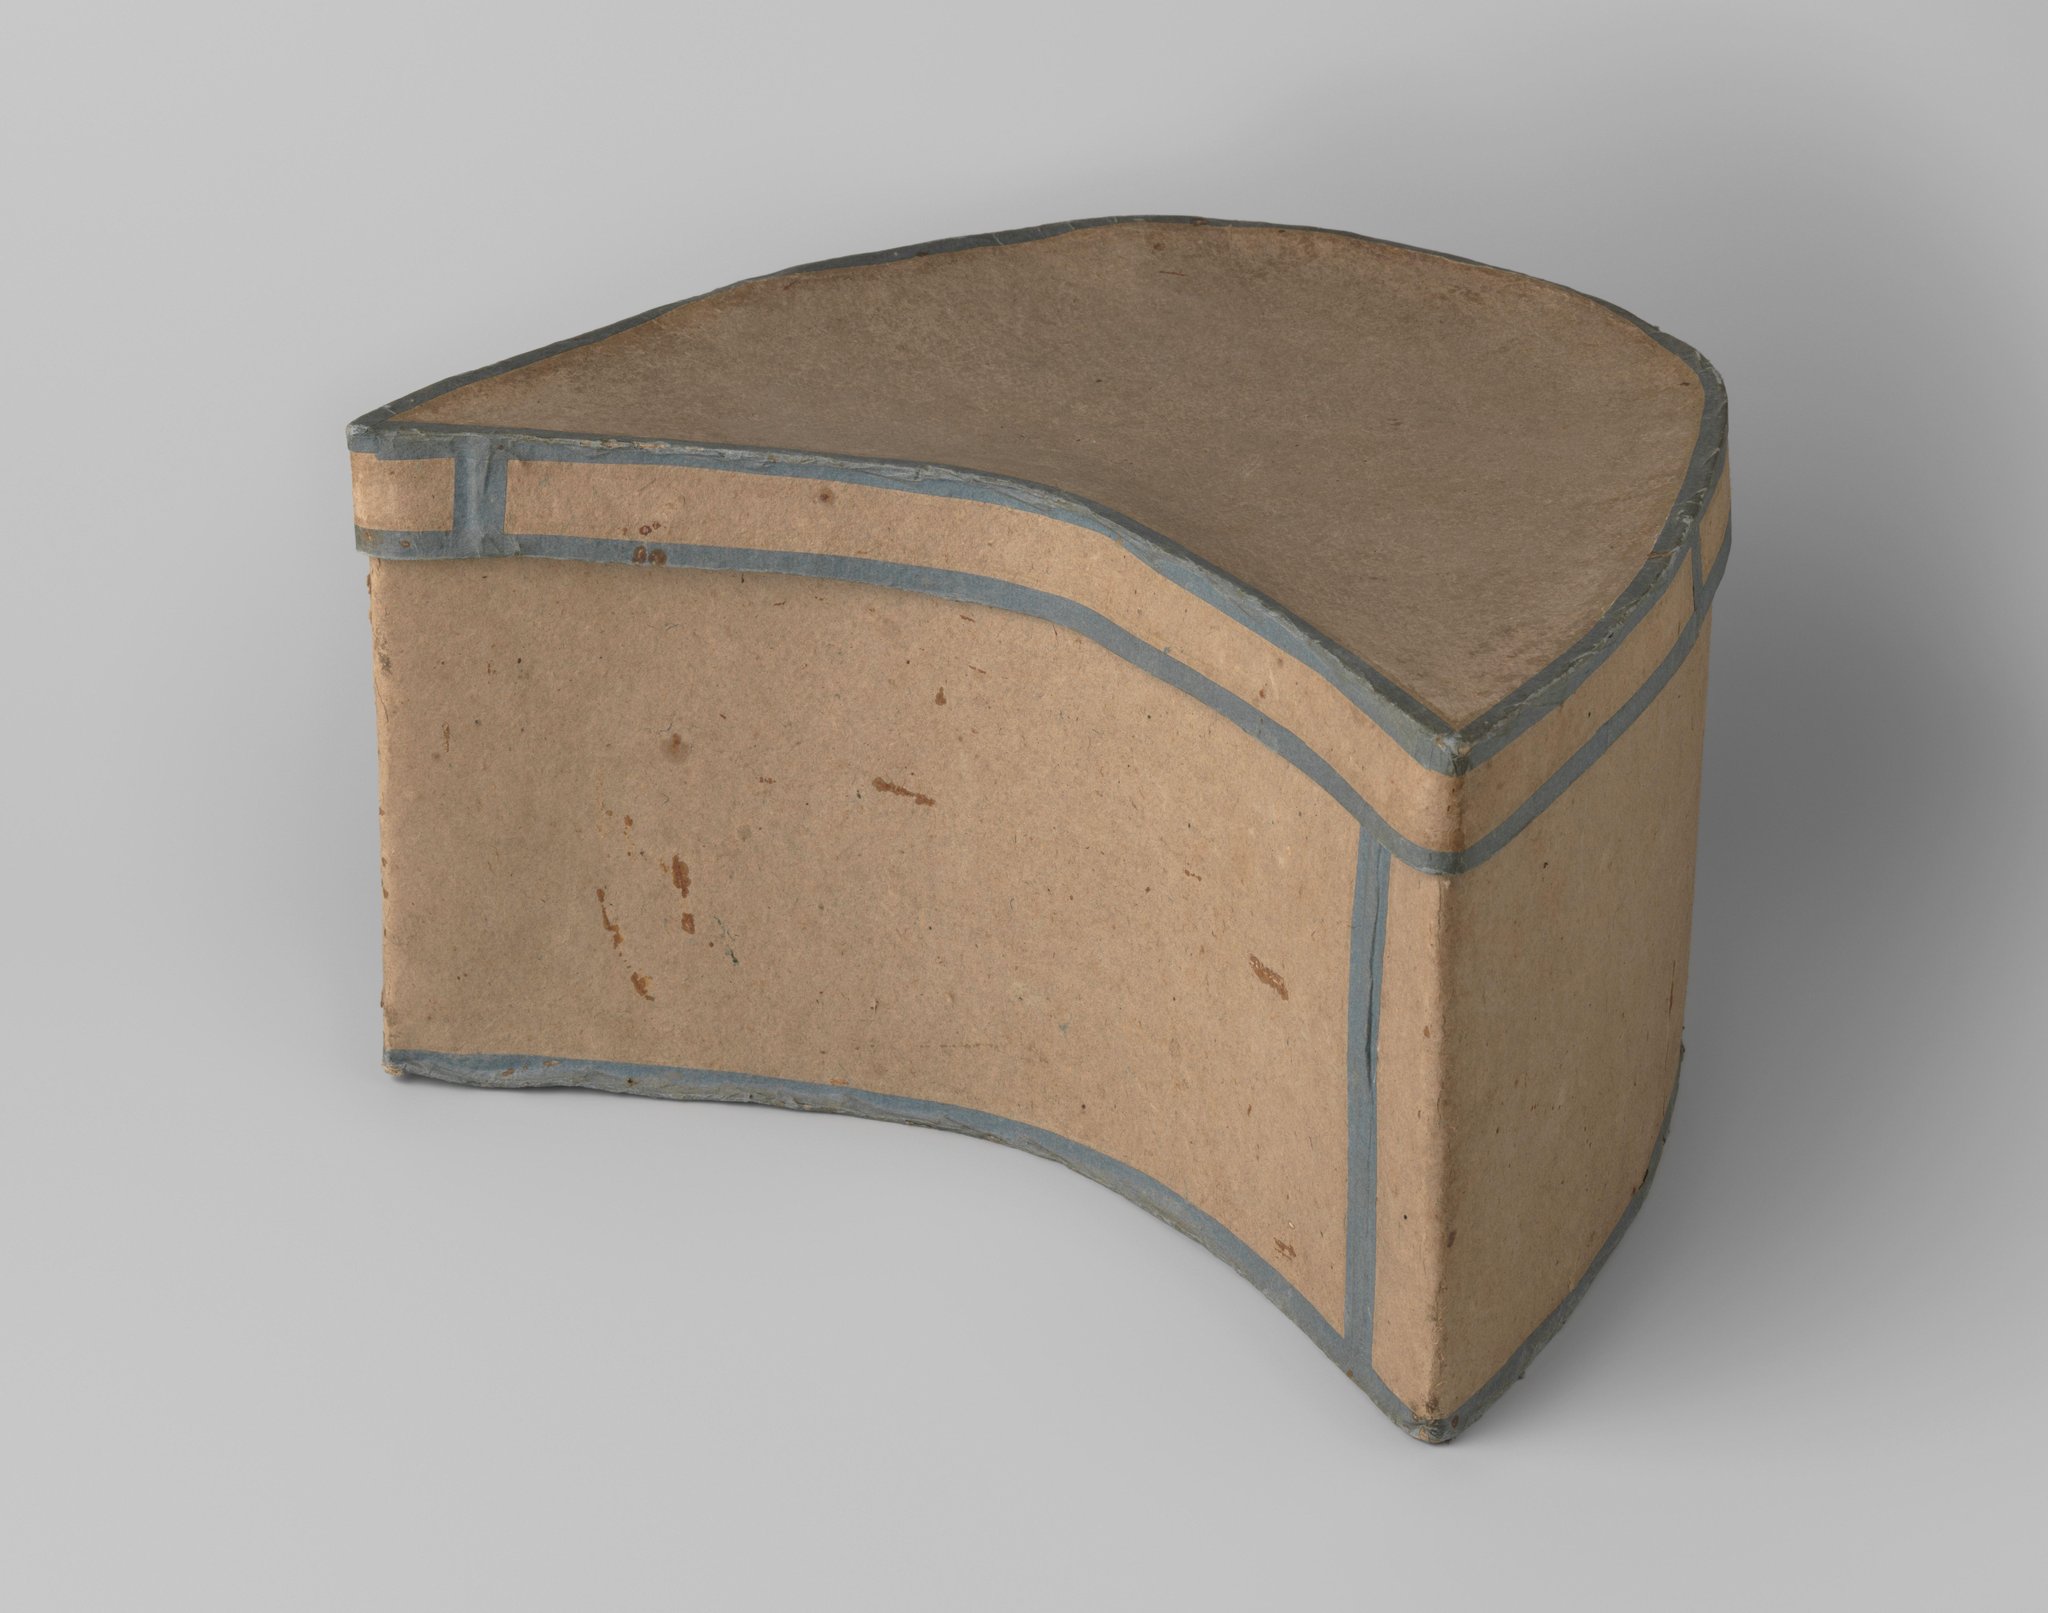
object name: verpakking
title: Halvemaanvormige lichtgrijze kartonnen doos met blauwe biezen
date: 1790-1810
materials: cardboard, paper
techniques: sewing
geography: amsterdam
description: Halvemaanvormige lichtgrijze kartonnen doos met blauwe biezen. Met losse deksel.